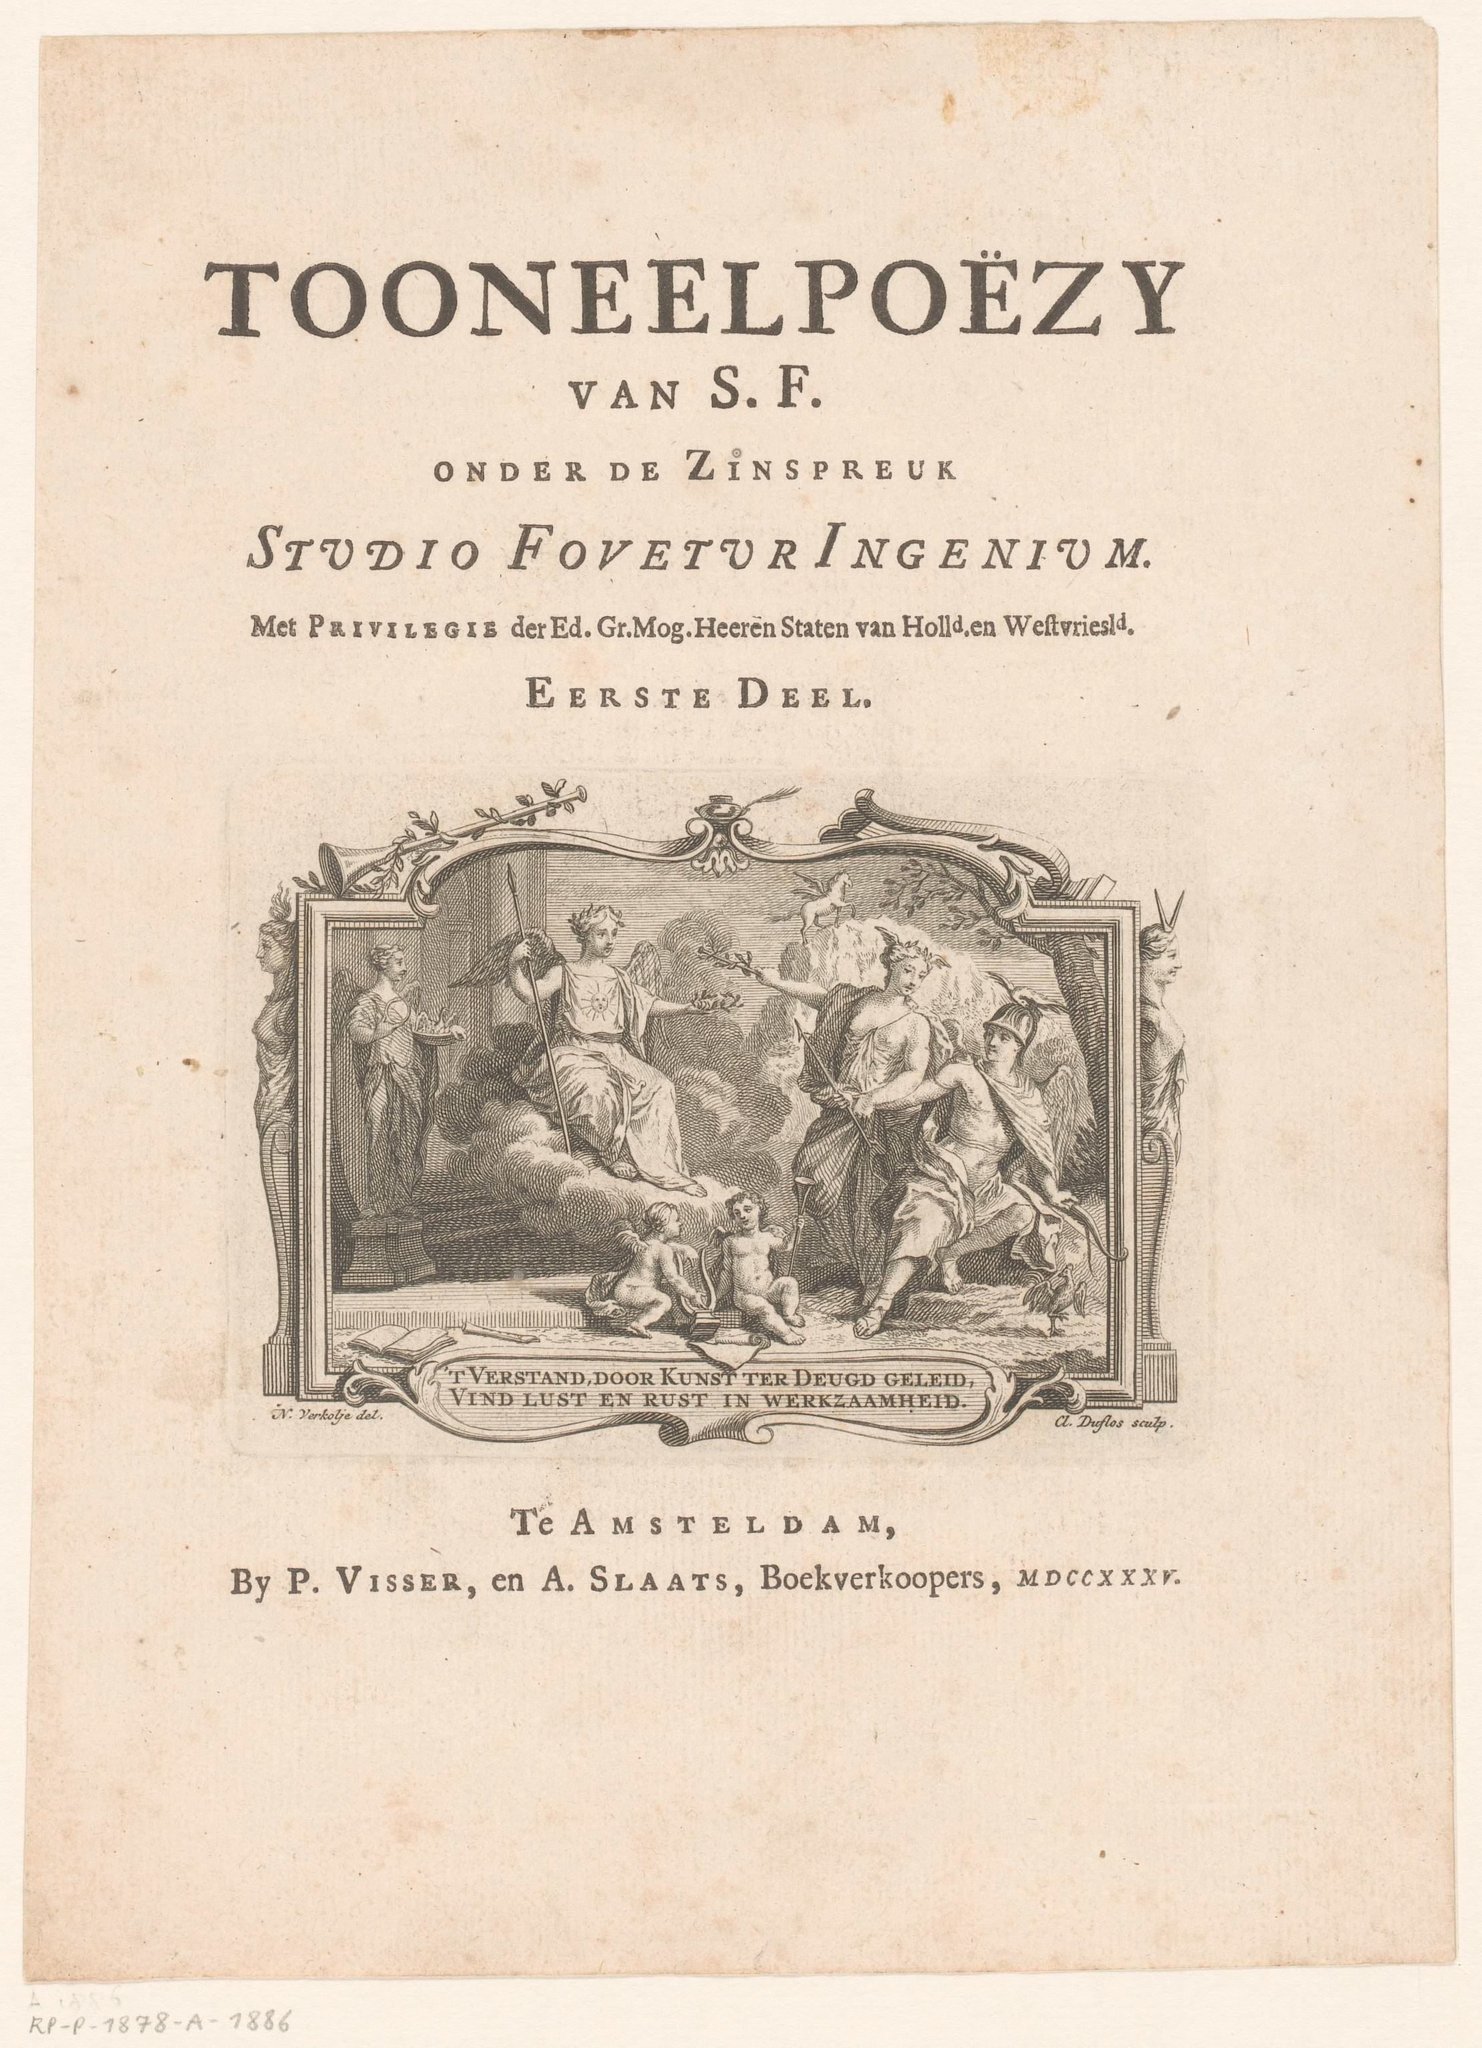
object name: titelblad, titelpagina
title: Titelpagina voor: Sybrand Feitema, Toneelpoëzy van S.F. onder de Zinspreuk Studio Fovetur Ingenium, 1735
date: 1735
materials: paper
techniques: engraving, etching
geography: france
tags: pegasus, the winged horse, intellect, intelligence; 'intelletto', 'intelligenza' (ripa), symbolic representations, allegories and emblems ~ art; 'arte' (ripa)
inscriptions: collector's mark: Lugt 2228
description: Prent uit: Feitema, Sybrand. Toneelpoëzy van S.F. onder de Zinspreuk Studio Fovetur Ingenium. Amsterdam: Pieter Visser en Adriaan Slaats, 1735, dl. 1.